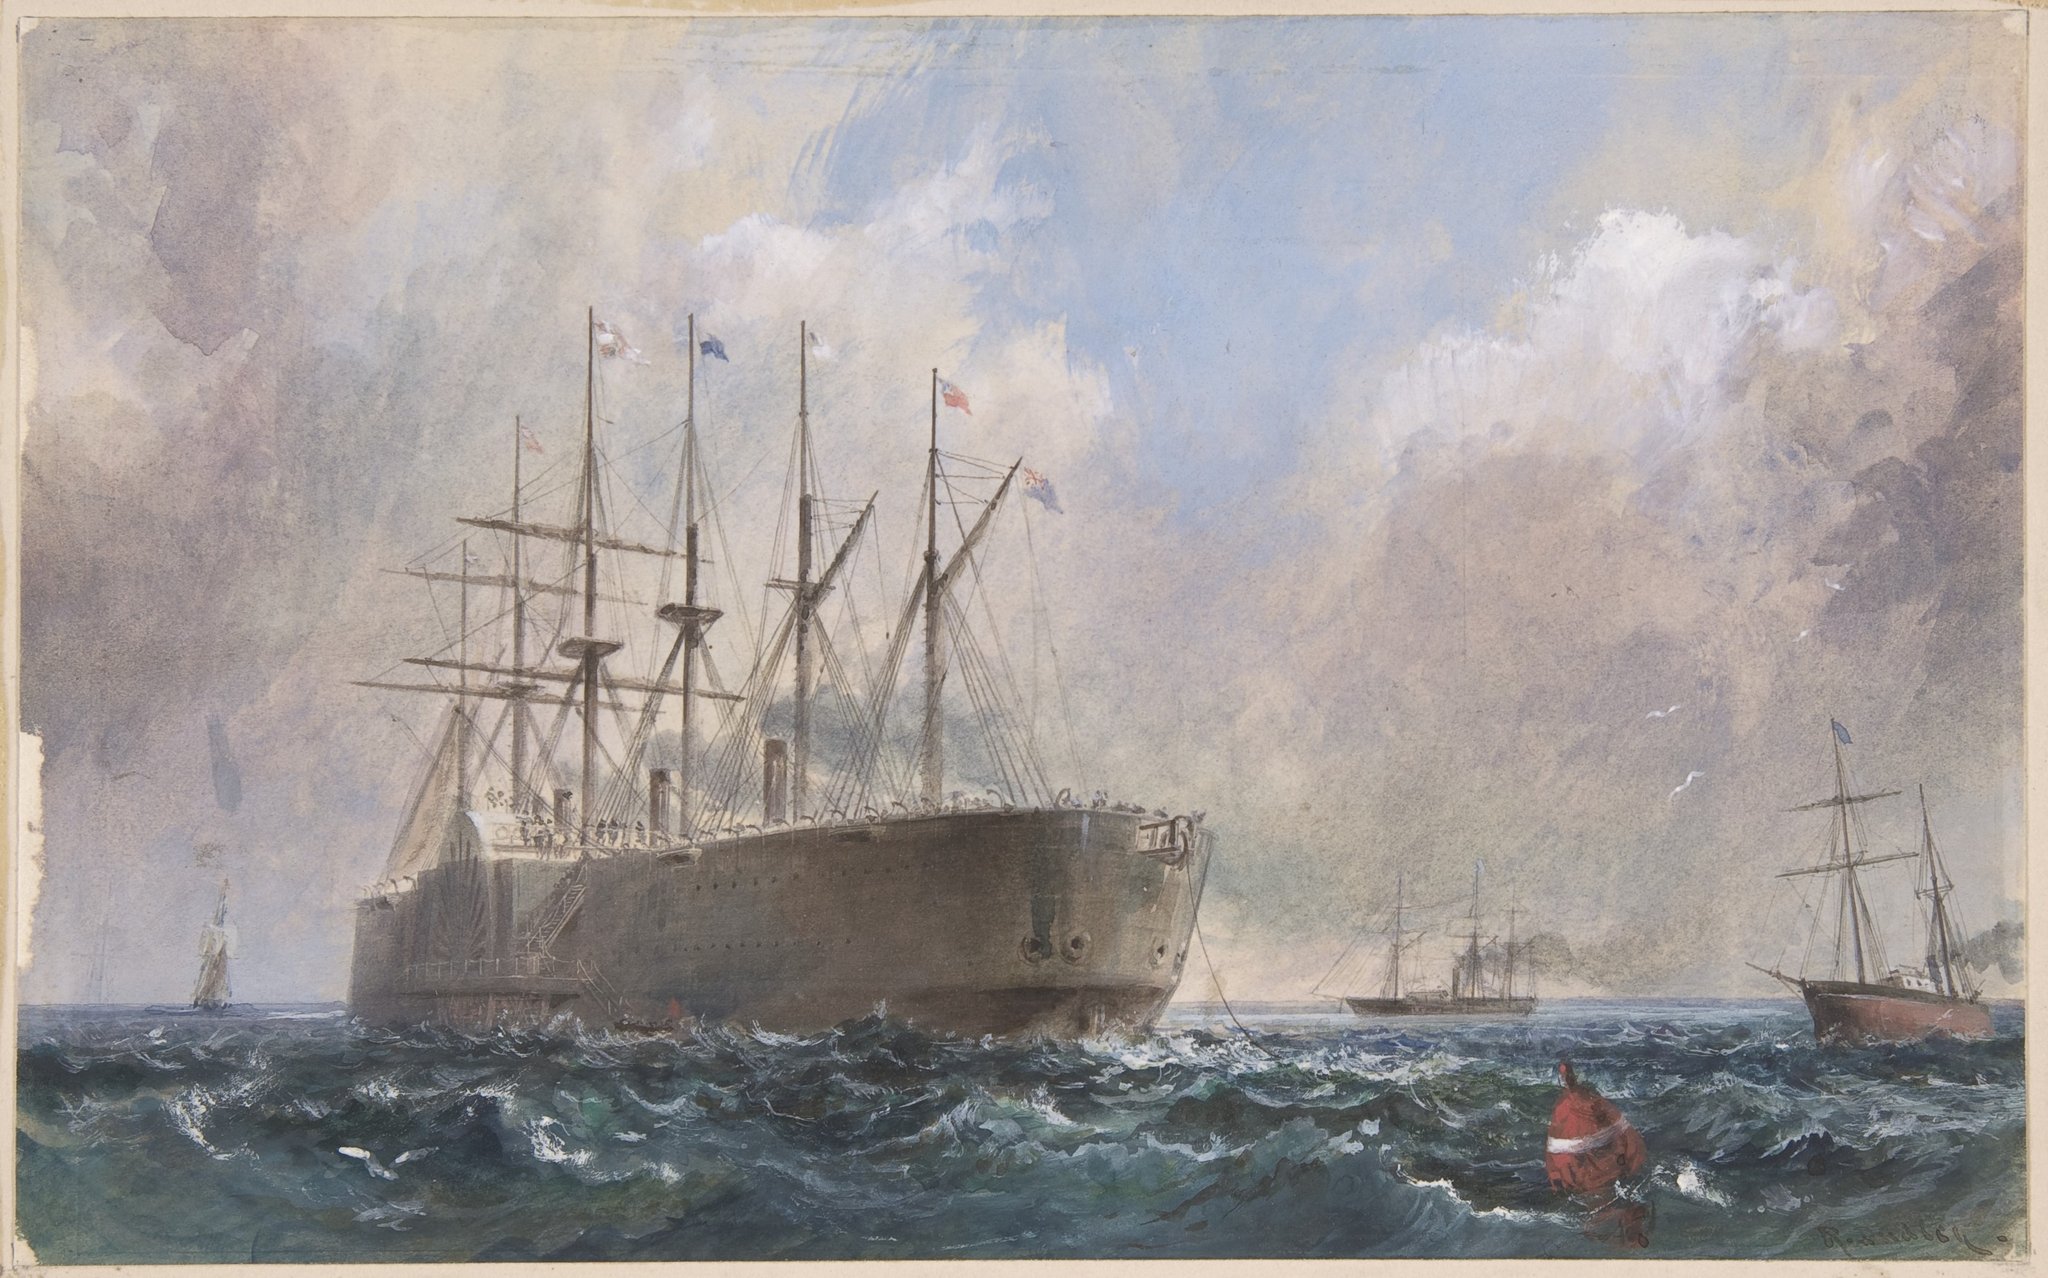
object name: drawing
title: Telegraph Cable Fleet at Sea, 1865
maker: robert charles dudley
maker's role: artist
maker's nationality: british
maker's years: 1826-1909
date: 1865-1866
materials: gouache, watercolor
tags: ships,transatlantic cable